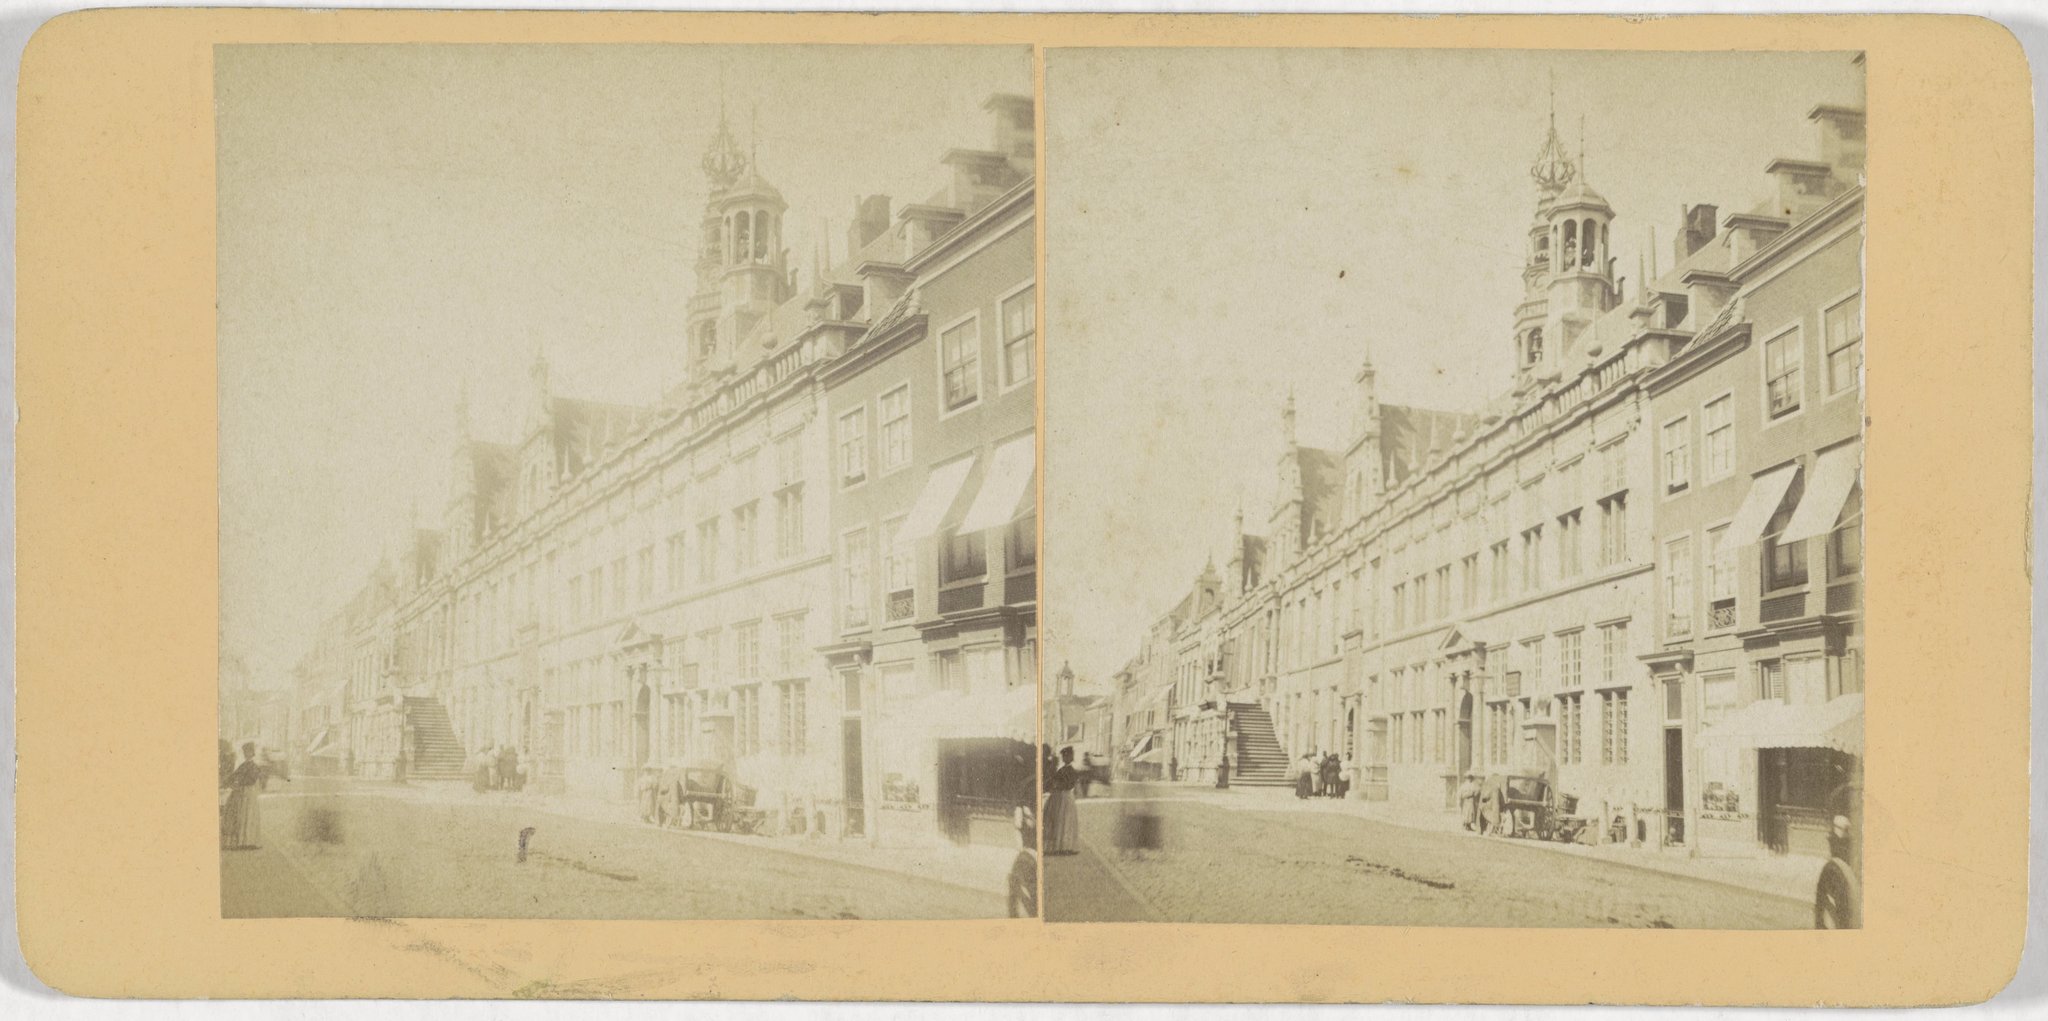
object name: stereograph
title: Stadhuis aan de Breestraat in Leiden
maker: Anonymous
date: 1873-1890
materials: cardboard, paper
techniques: albumen print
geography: leiden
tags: townhall, street